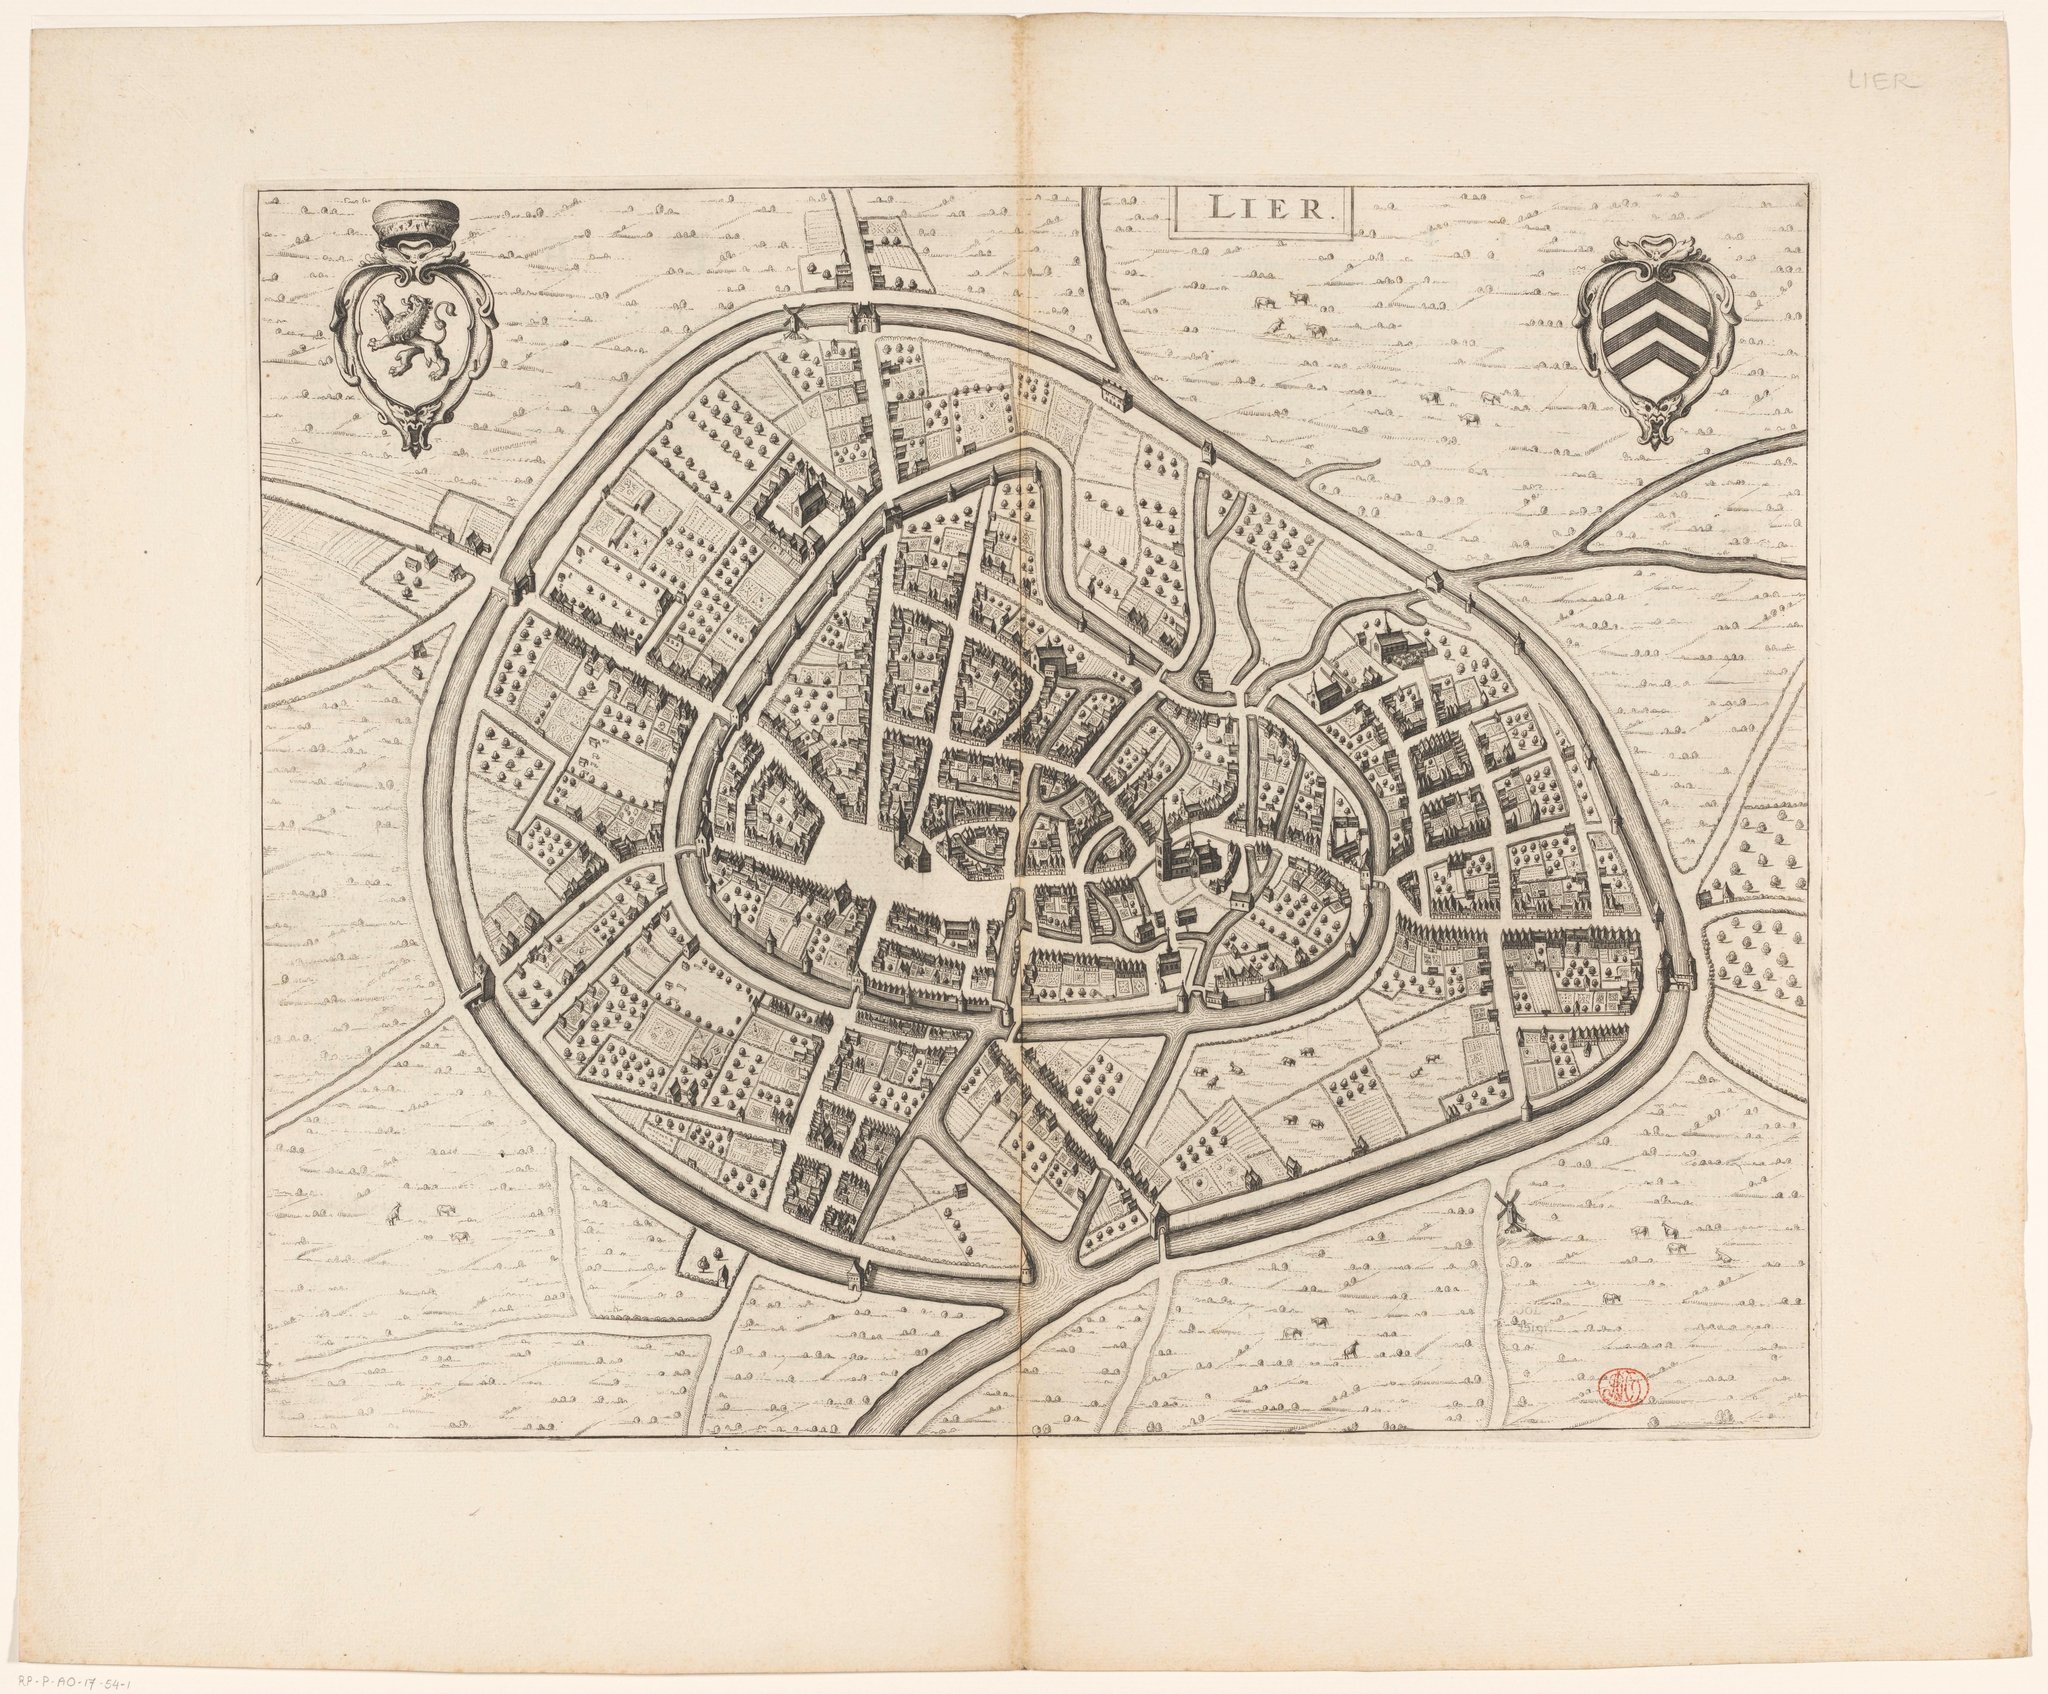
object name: area plan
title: Lier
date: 1652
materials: paper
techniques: engraving, etching, letterpress printing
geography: amsterdam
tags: coat of arms (as symbol of the state, etc.) (+ city; municipal), maps of cities, coat of arms (as symbol of the state, etc.) (+ province; provincial), lierre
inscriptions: collector's mark: Lugt 195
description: Plattegrond van Lier met gebouwen in vogelvluchtperspectief. Boven, rechts van het midden, de titelcartouche. Linksboven het wapen van Brabant. Rechtsboven het wapen van Lier. Op verso Nederlandse tekst.